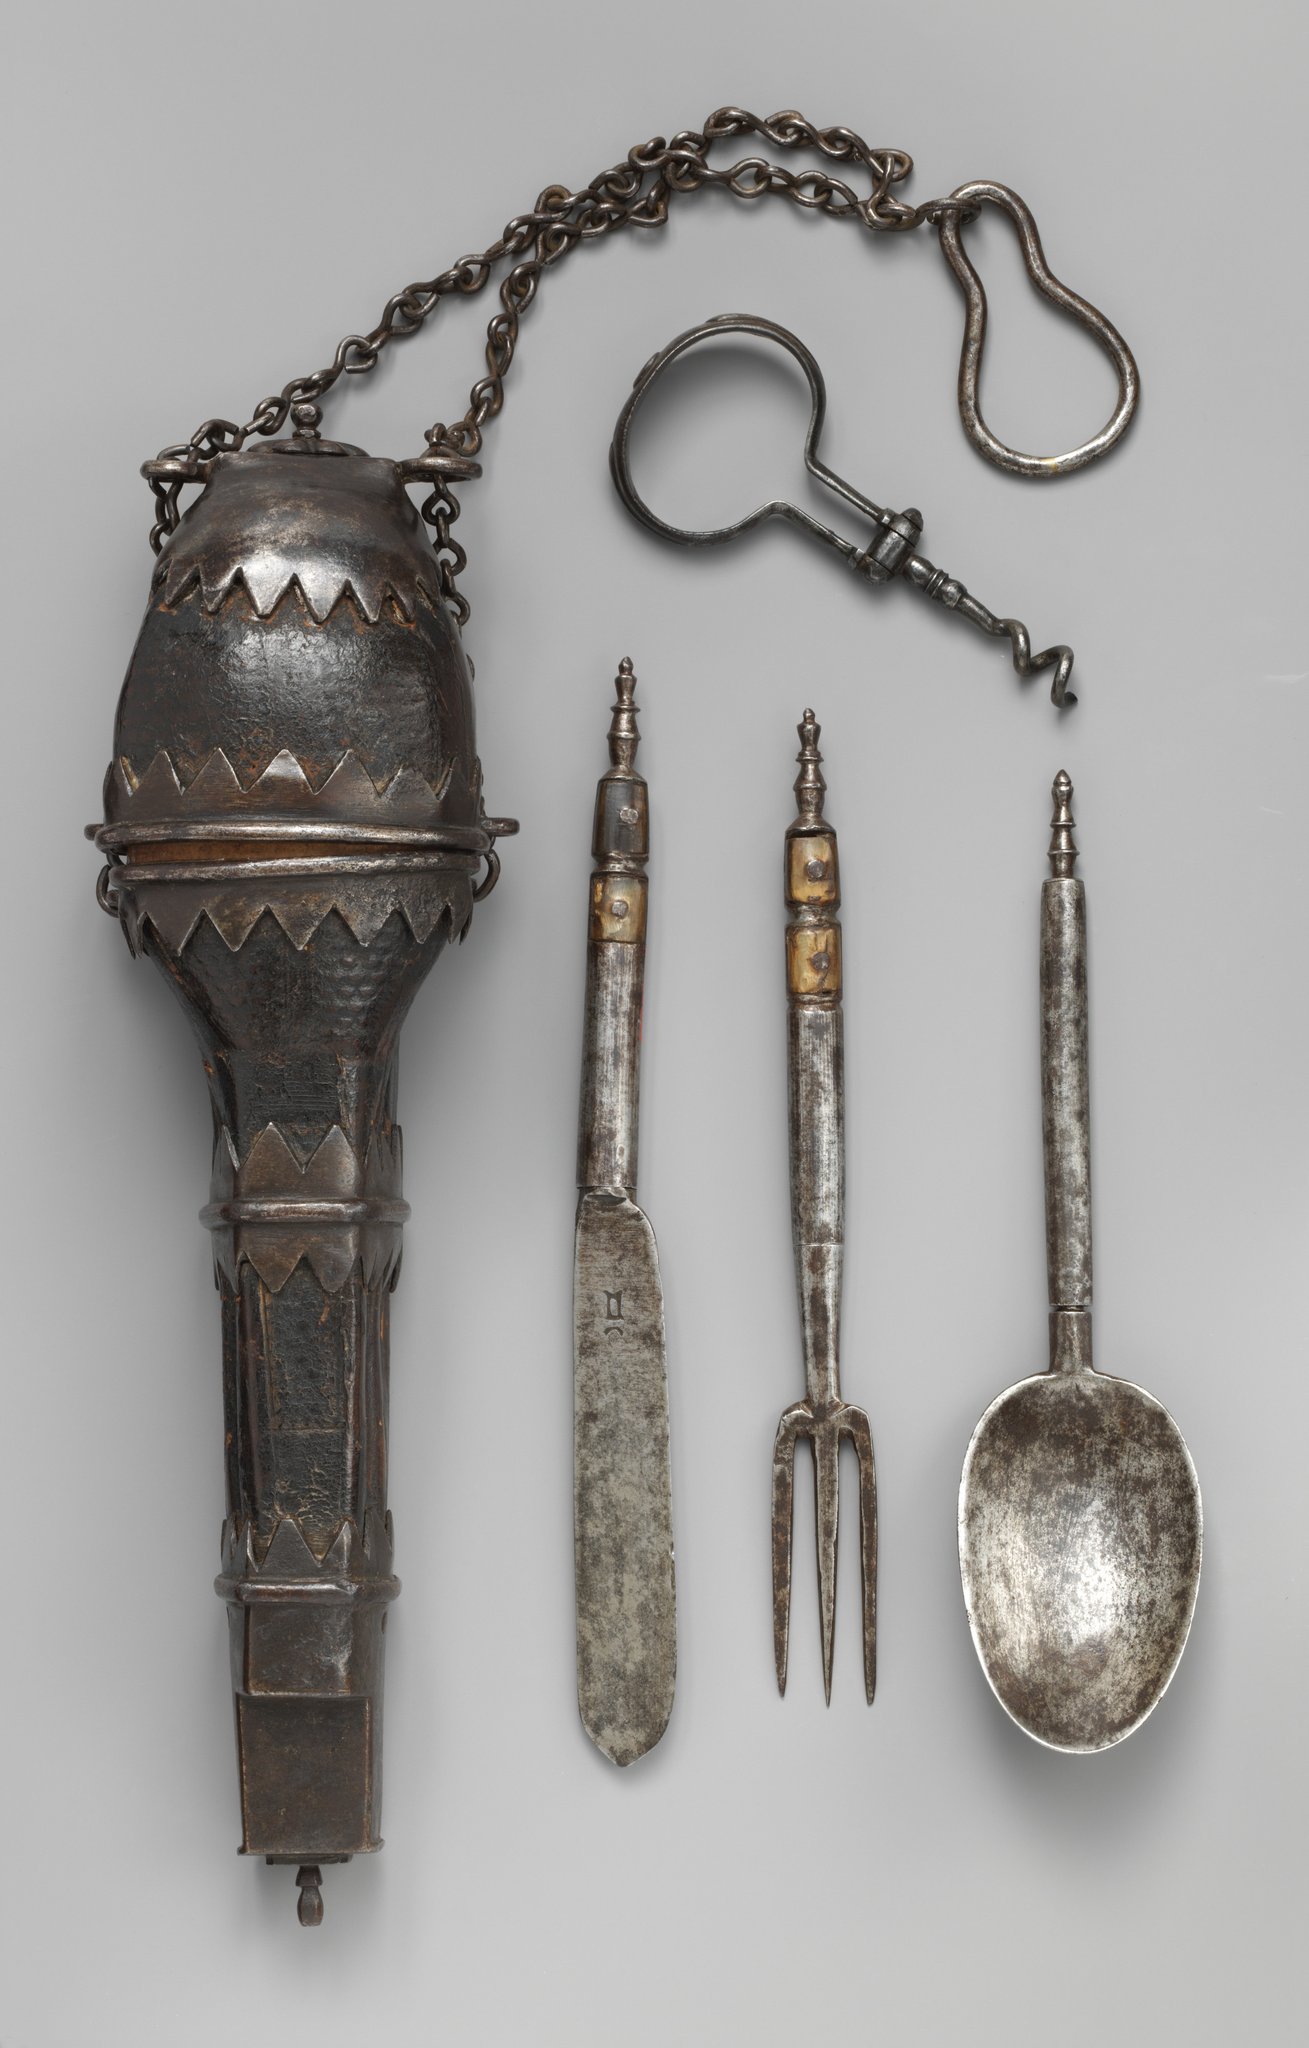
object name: cutlery in case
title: Knife, fork, spoon, and corkscrew in a case (Étui de couvert)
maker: Anonymous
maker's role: maker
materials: horn, iron, leather, steel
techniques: inlay